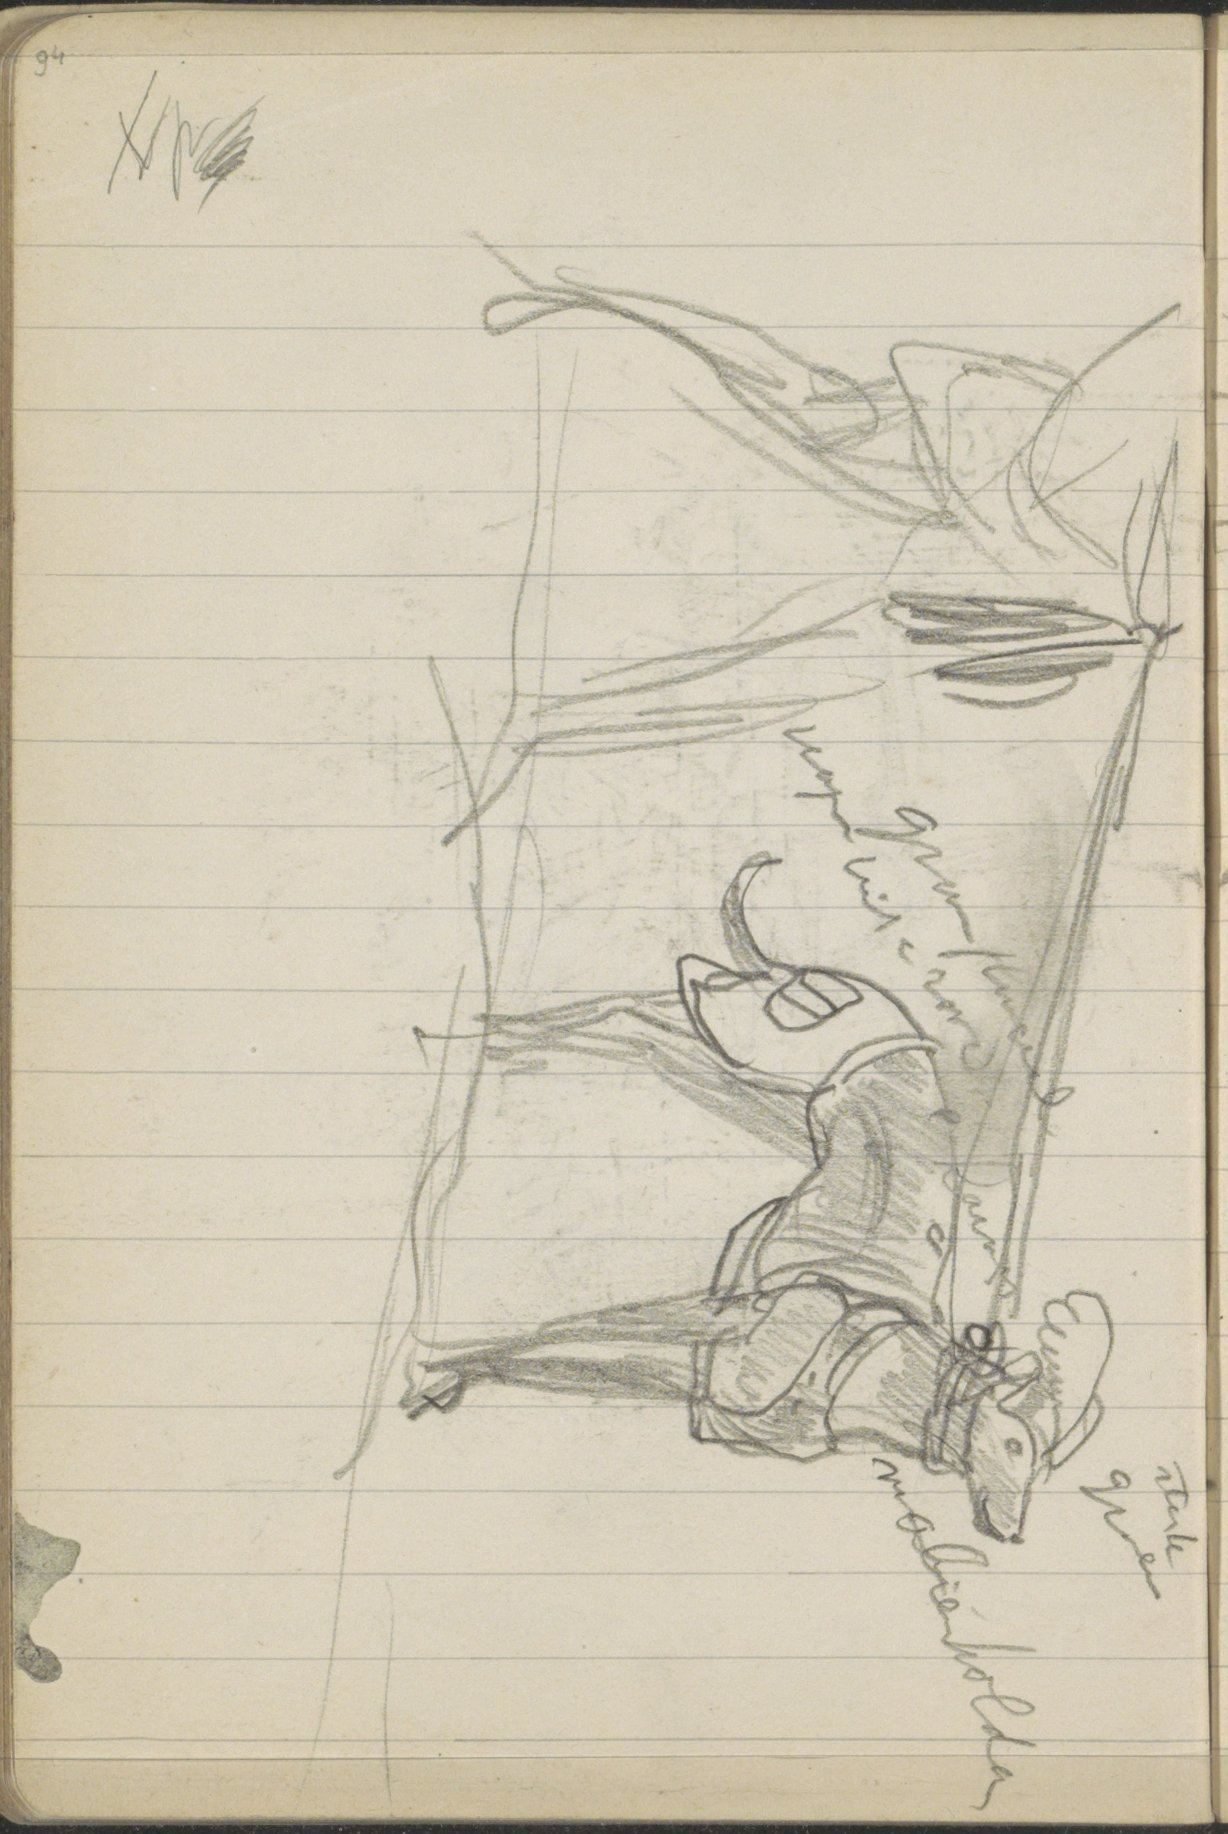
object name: sketchbook leaf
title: Figuur met aan een lijn een hond met een versierd tuig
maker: marius bauer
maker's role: draughtsman, print maker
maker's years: 1867-1932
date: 1902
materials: pencil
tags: harness, walking the dog, dog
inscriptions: annotation: ‘malienkolder’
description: Pagina 94 uit een schetsboek met 50 bladen.